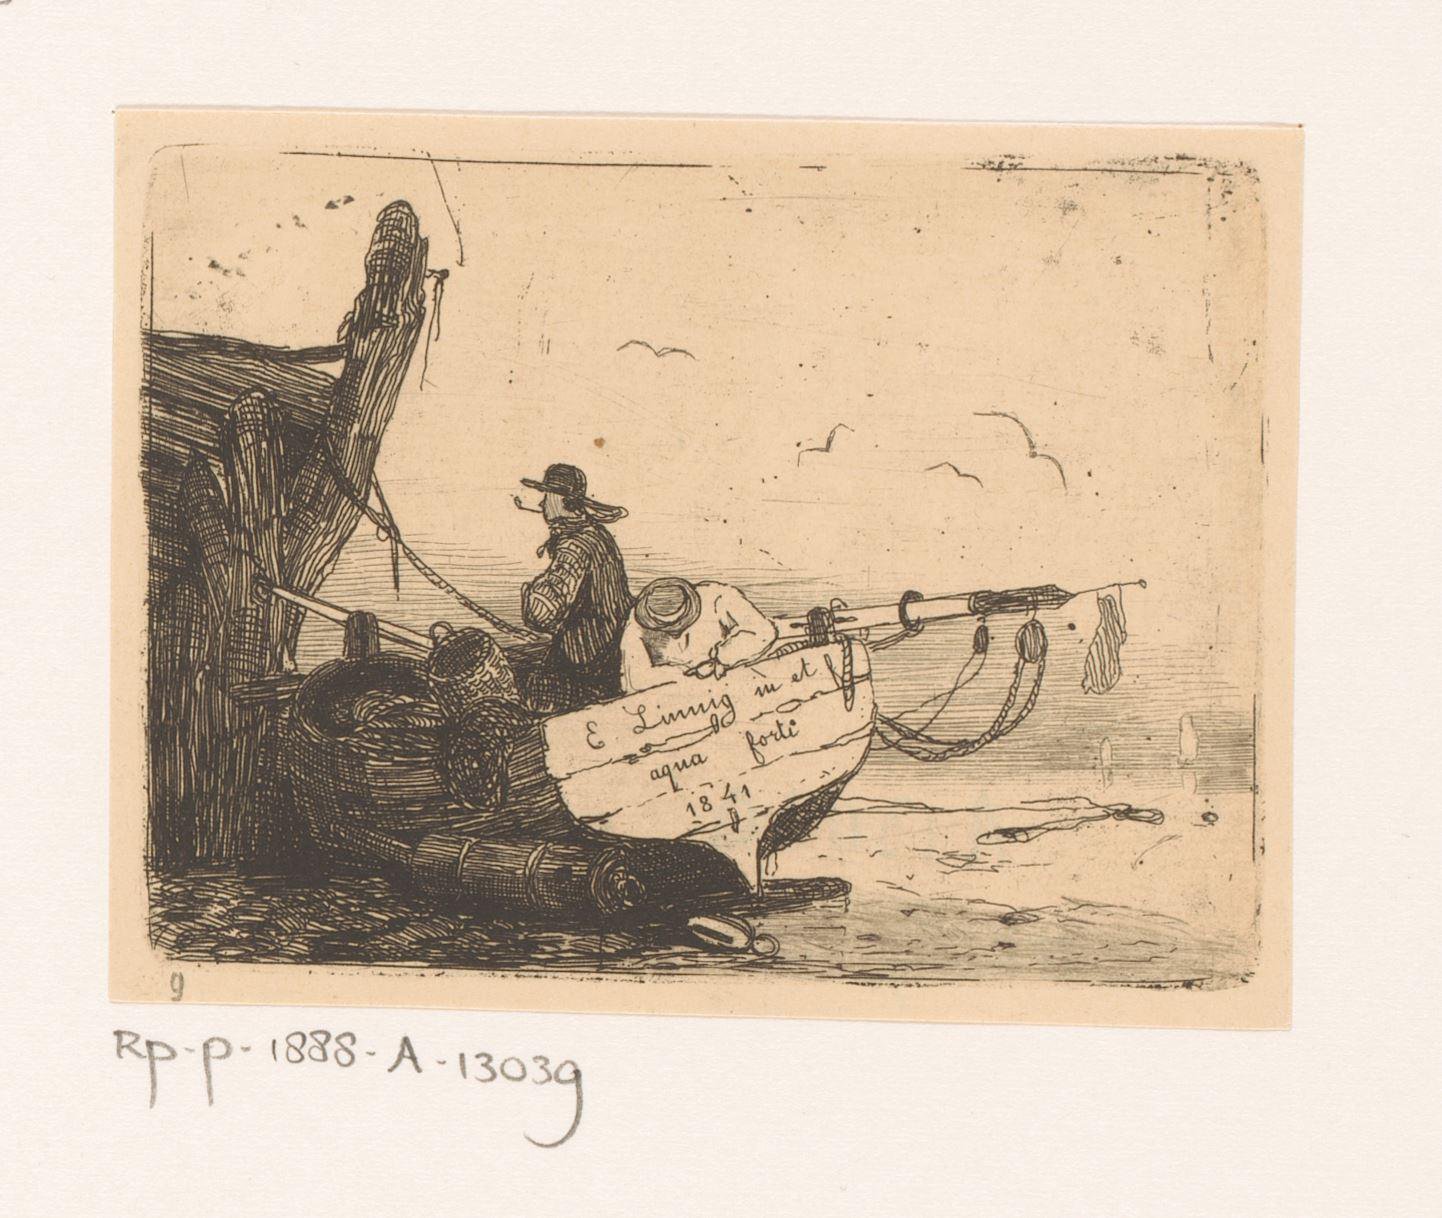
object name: print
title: Twee mannen in een sloep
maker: egidius linnig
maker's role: draughtsman, print maker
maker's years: 1821-1860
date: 1841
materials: paper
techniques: drypoint, etching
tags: rowing-boat, canoe, etc.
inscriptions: collector's mark: Lugt 2228